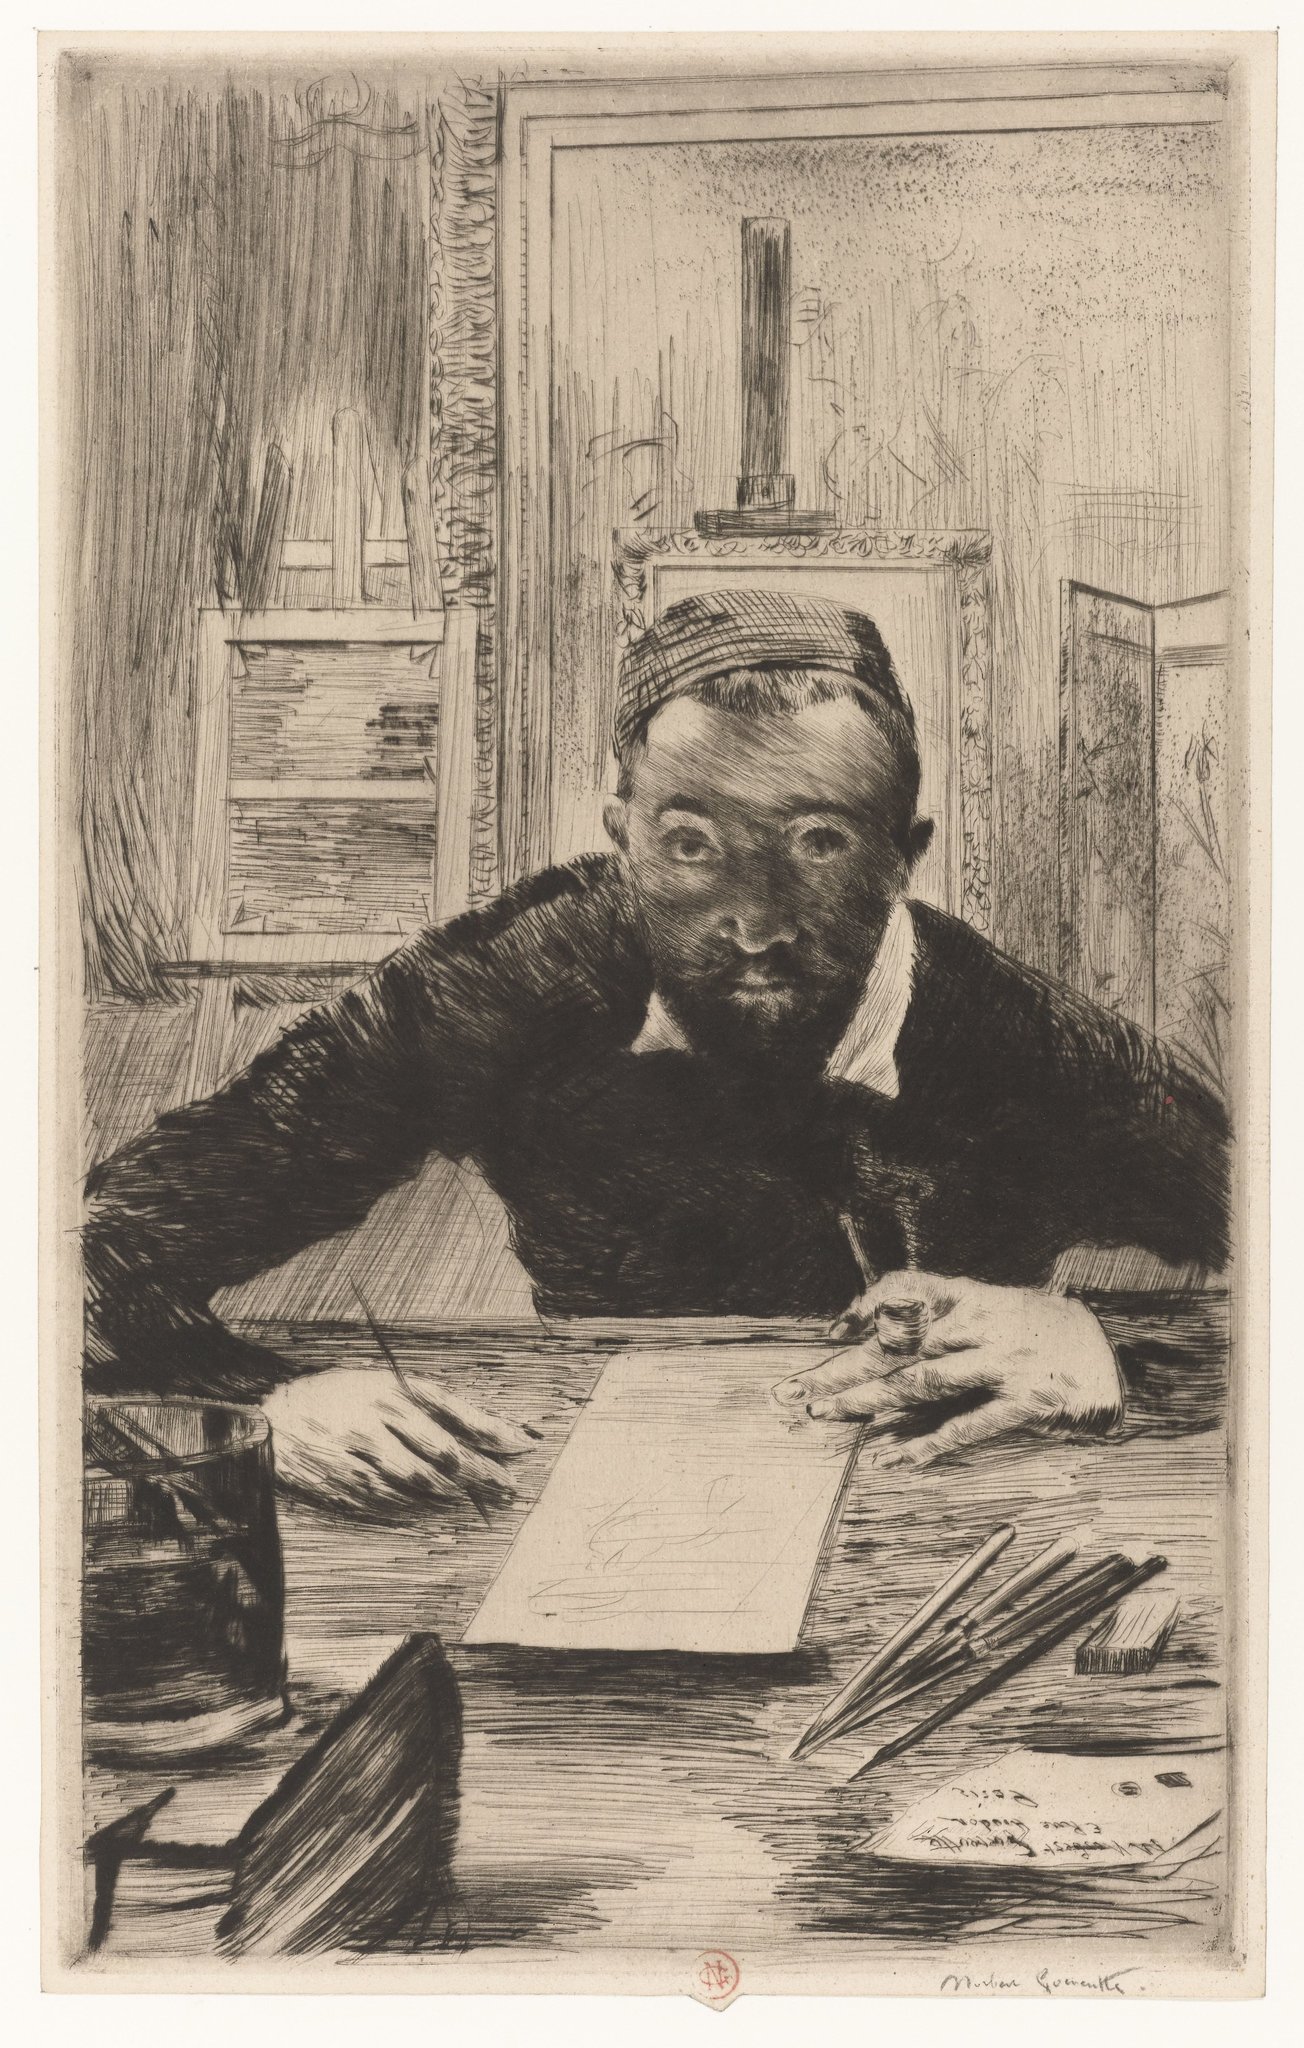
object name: print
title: Zelfportret van Norbert Goeneutte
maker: norbert goeneutte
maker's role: draughtsman, painter, print maker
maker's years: 1854-1894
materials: paper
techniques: drypoint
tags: paris, painter, print maker, draughtsman, norbert goeneutte, historical persons, portrait, self-portrait of artist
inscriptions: collector's mark: Lugt 2228, stamp: Lugt 1182